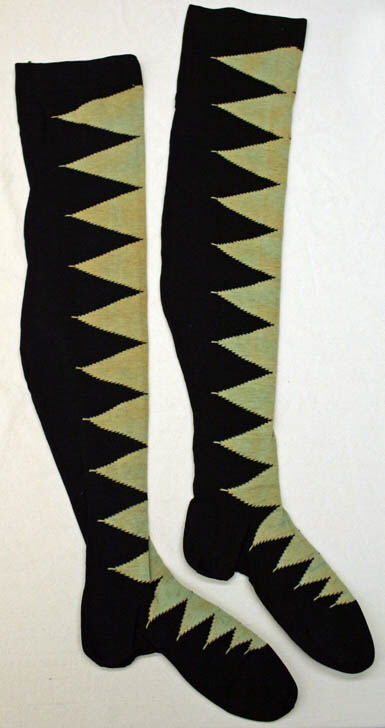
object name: stocking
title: Stockings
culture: american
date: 1890-1899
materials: silk